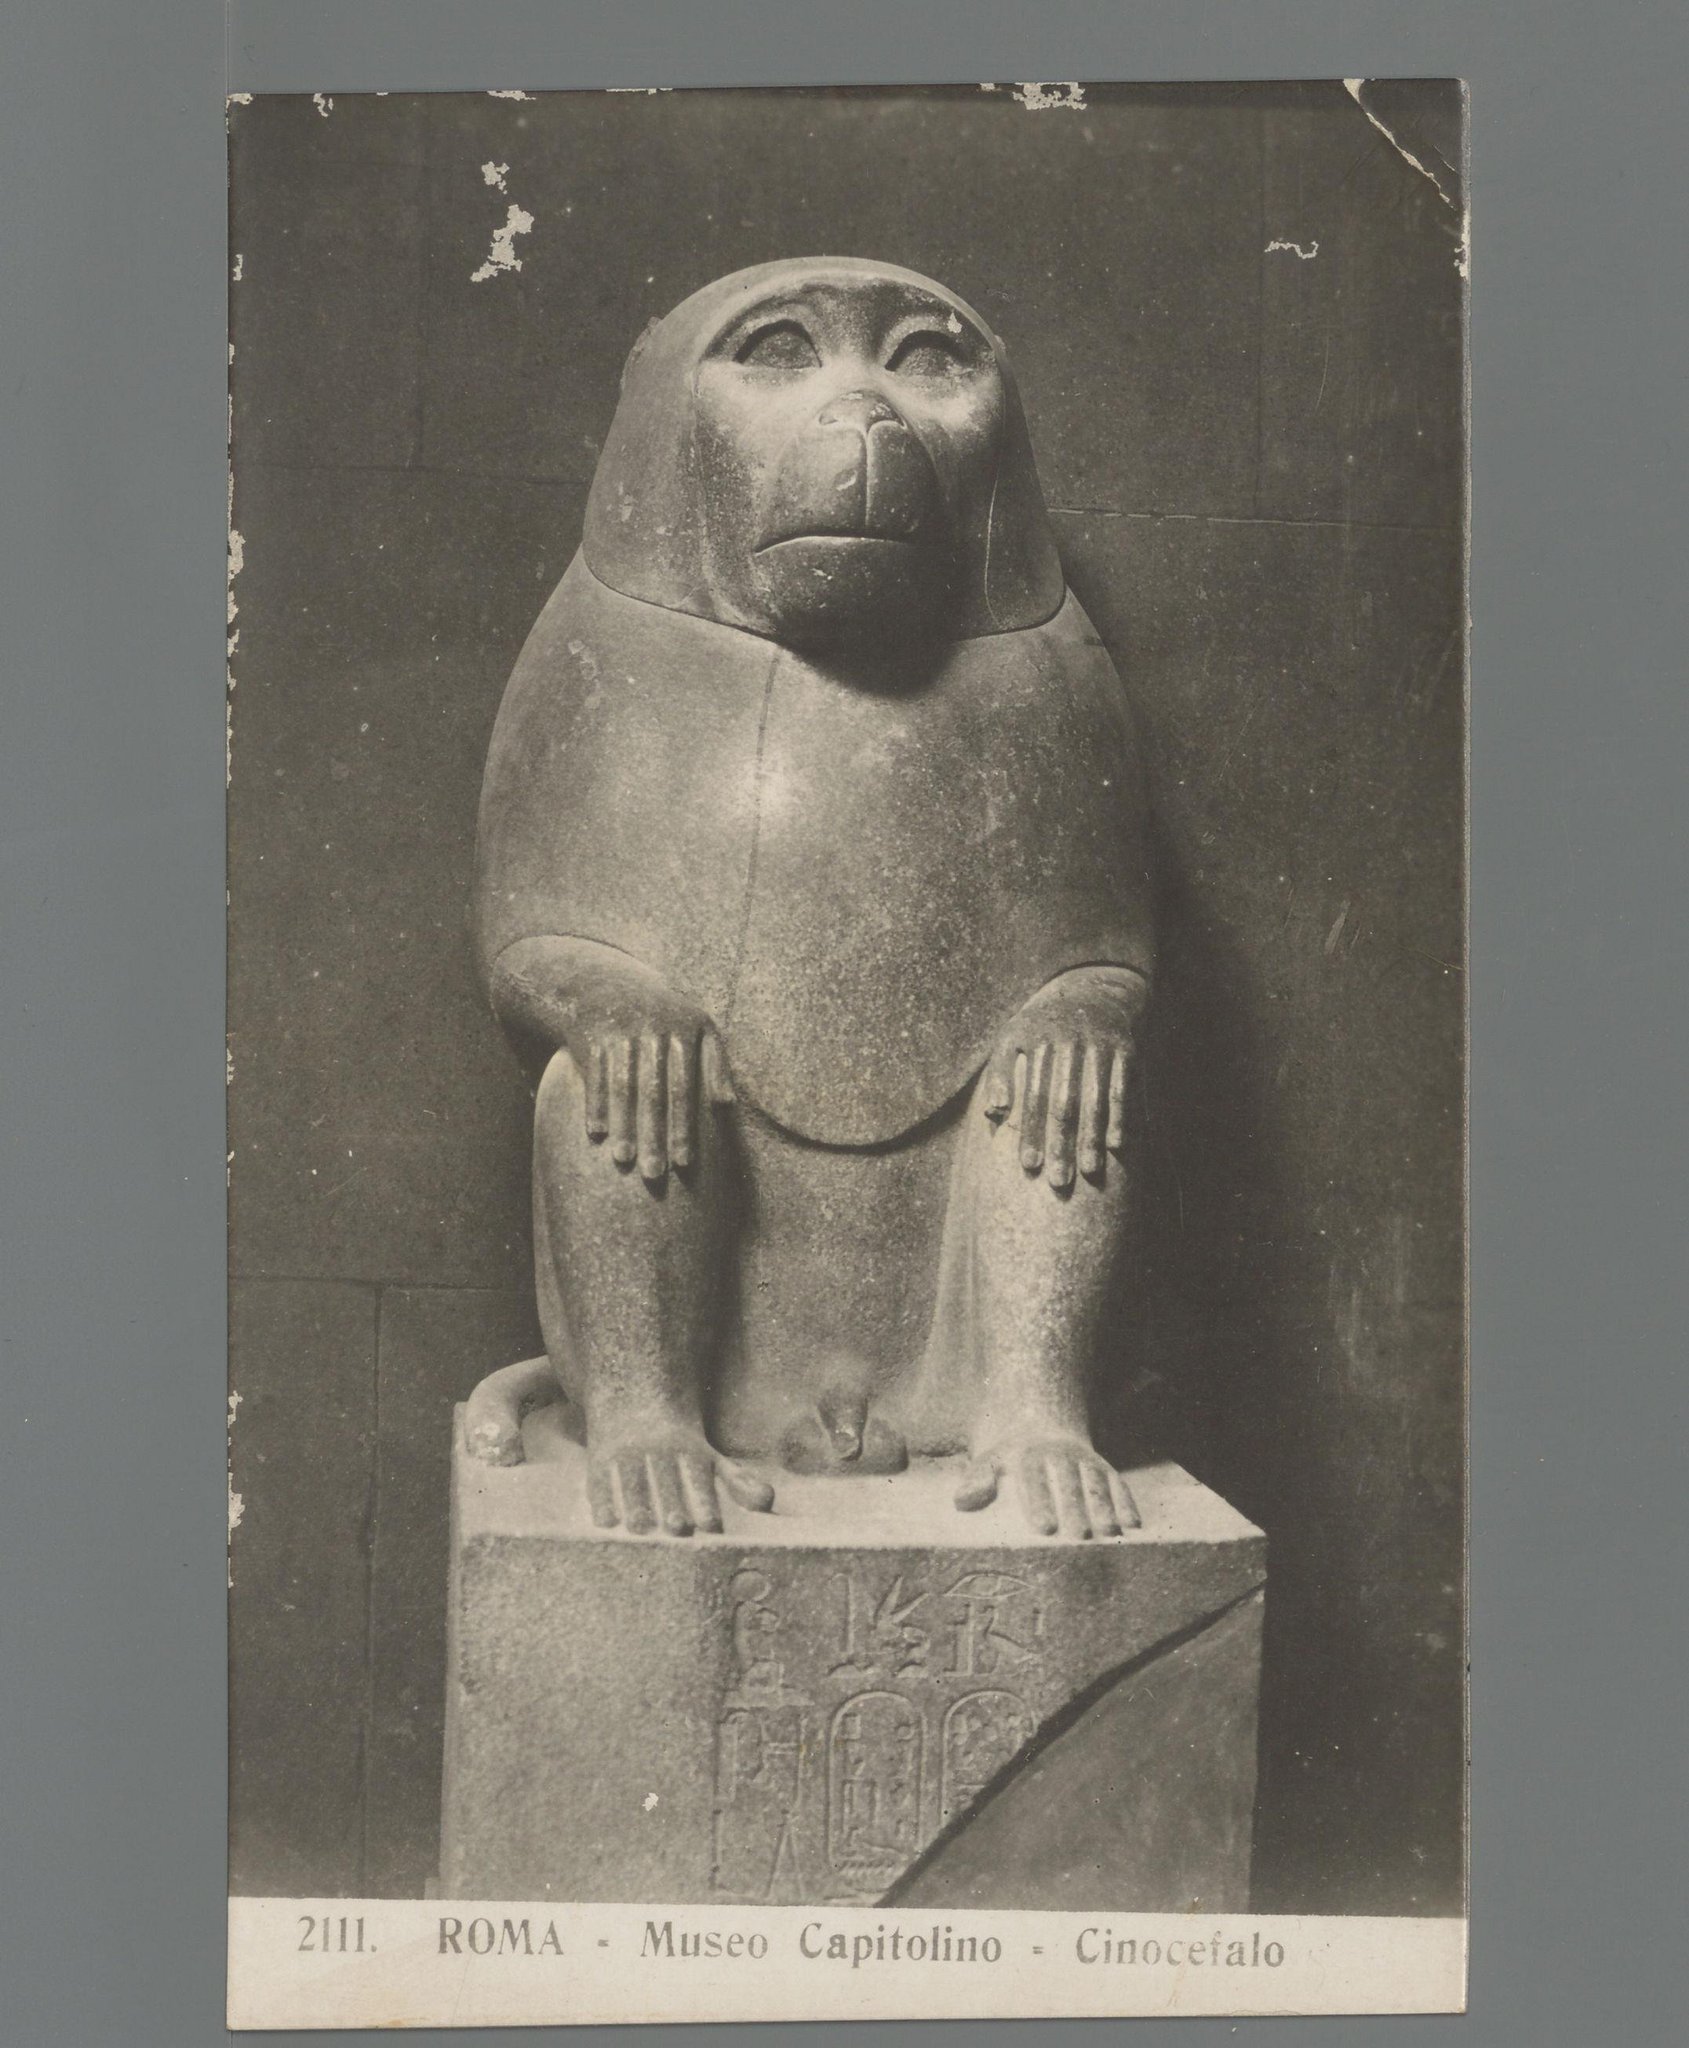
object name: photograph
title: Roma - Museo Capitolino - Cinocefalo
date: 1906-1927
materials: paper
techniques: gelatin silver print, writing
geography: rome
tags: statues, paintings, etc. ~ objects of worship (egyptian religion), permanent exhibition, museum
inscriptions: postage stamp, collector's mark: ‘AFE v S’